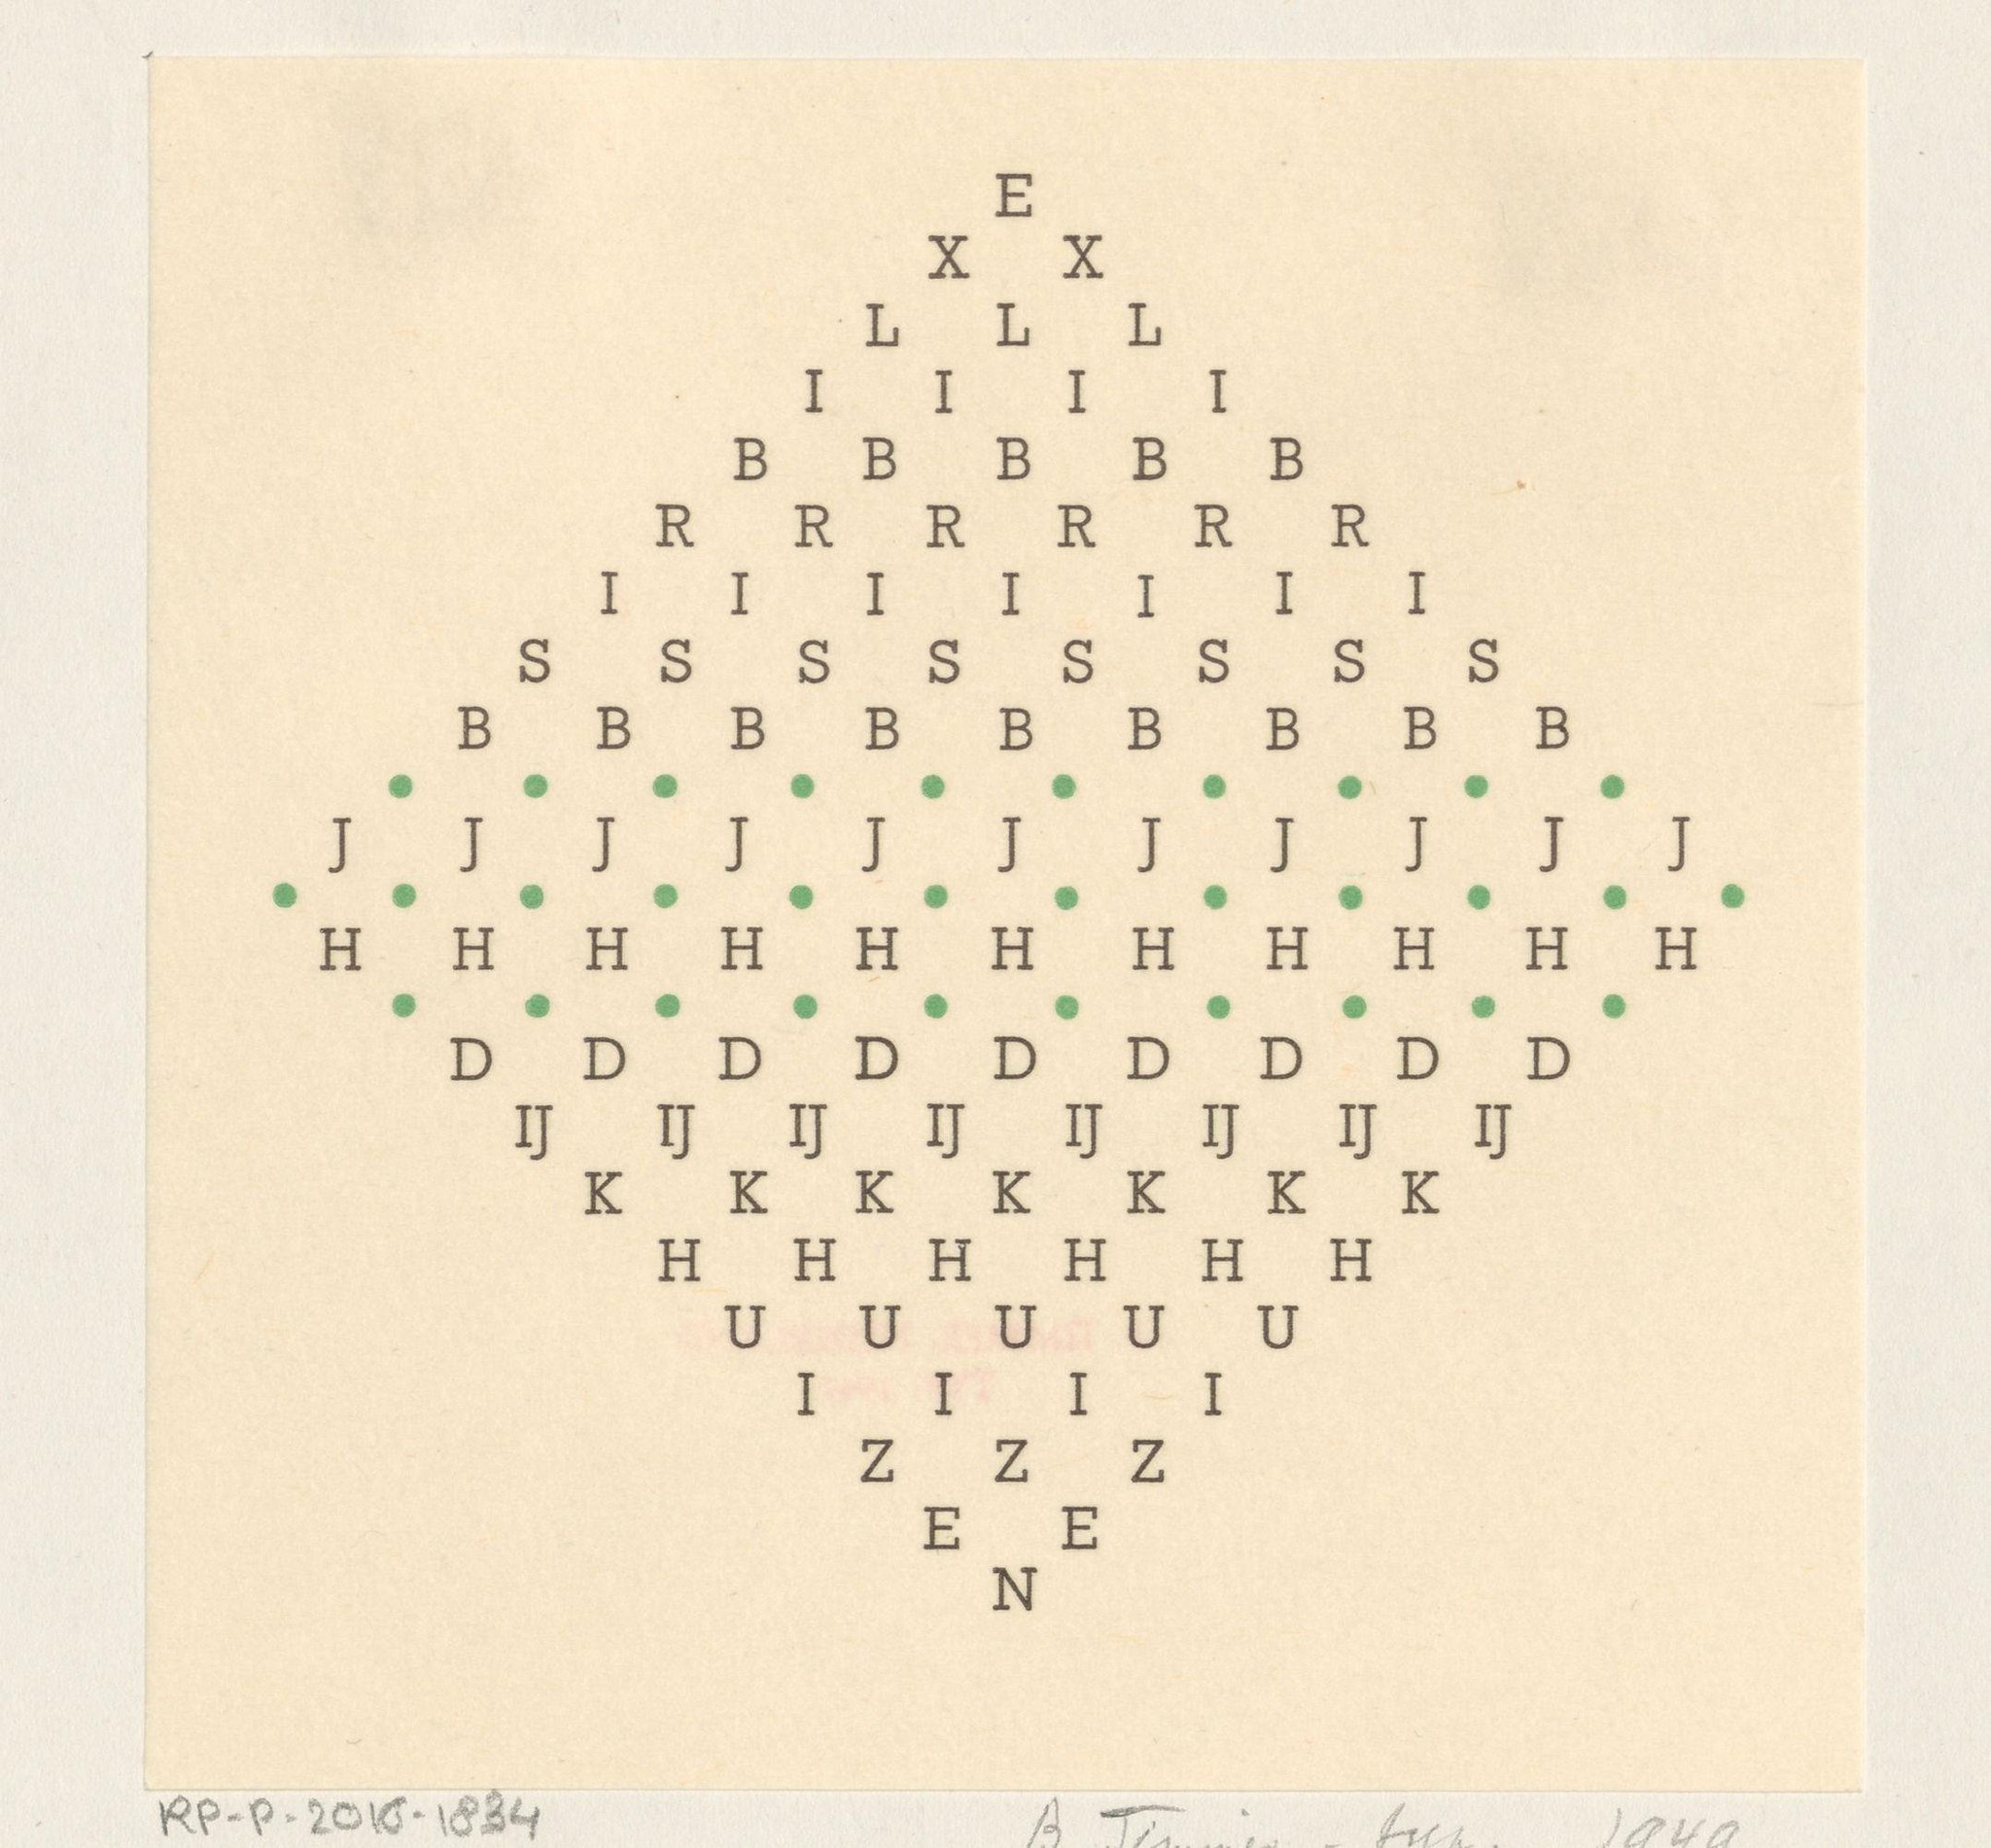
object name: bookplate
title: Ex libris van B.J.H. Dijkhuizen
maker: b. timmer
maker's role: print maker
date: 1949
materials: paper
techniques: printing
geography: netherlands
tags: b.j.h. dijkhuizen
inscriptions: workshop stamp: ‘B. Timmer Nederland / Typ. 1949’